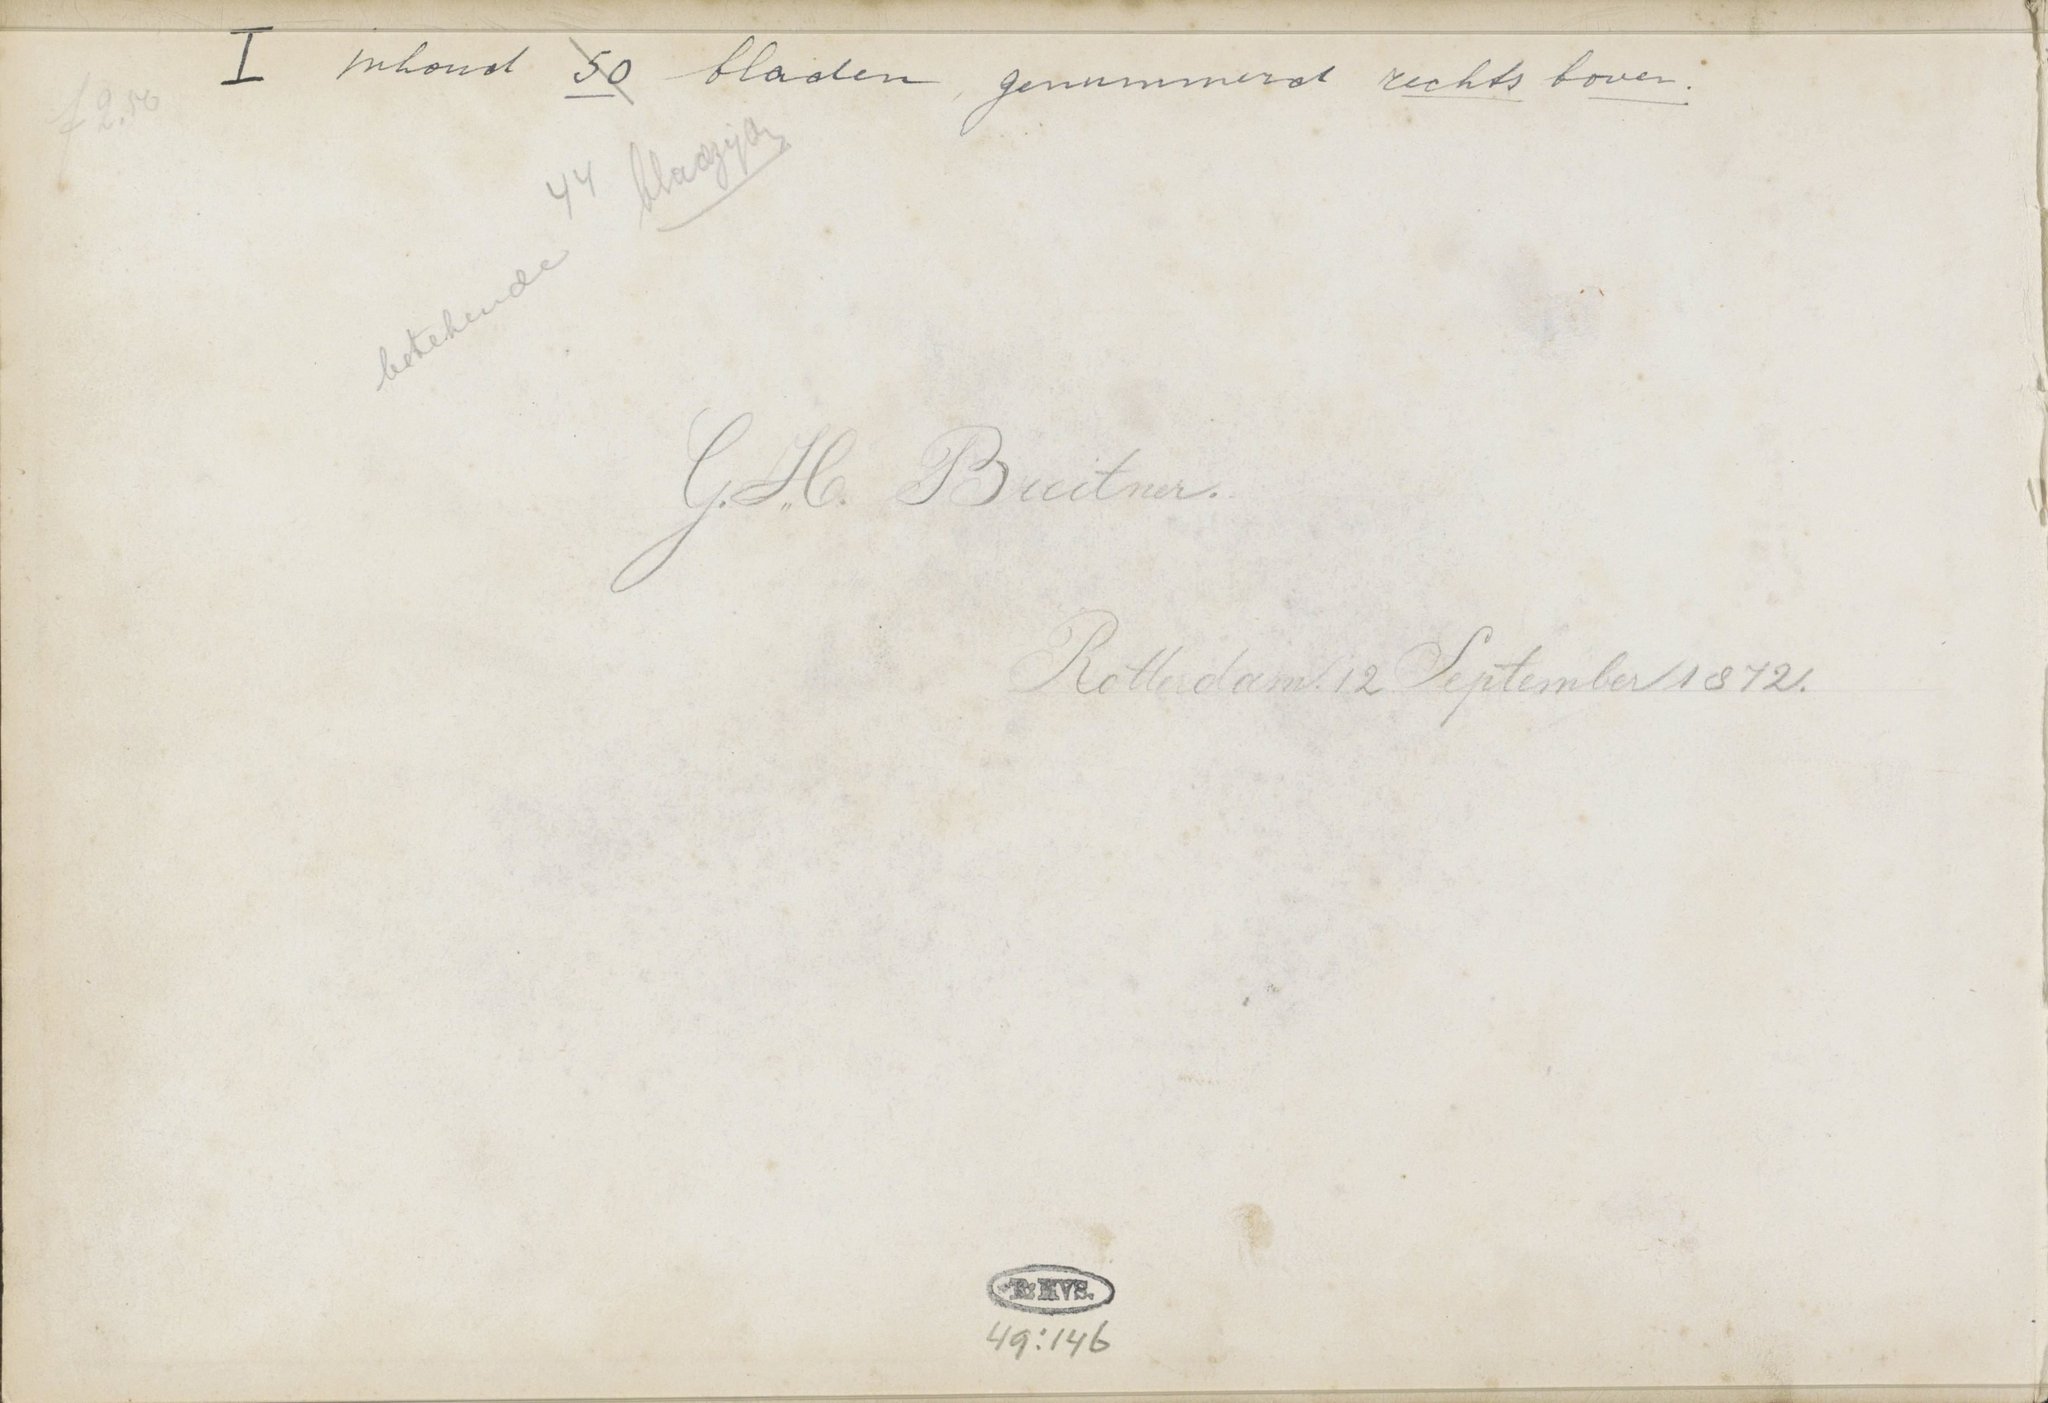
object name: sketchbook leaf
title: Signatuur en datum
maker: george hendrik breitner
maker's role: draughtsman, painter, print maker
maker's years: 1857-1923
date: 1809-1872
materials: paper, pencil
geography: rotterdam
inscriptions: signature: ‘G.H. Breitner.’, annotation: ‘Rotterdam’, collector's mark: Lugt 2228, date: ‘12 September 1872’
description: Schutblad A, voorste schutblad, uit een schetsboek met 32 bladen.